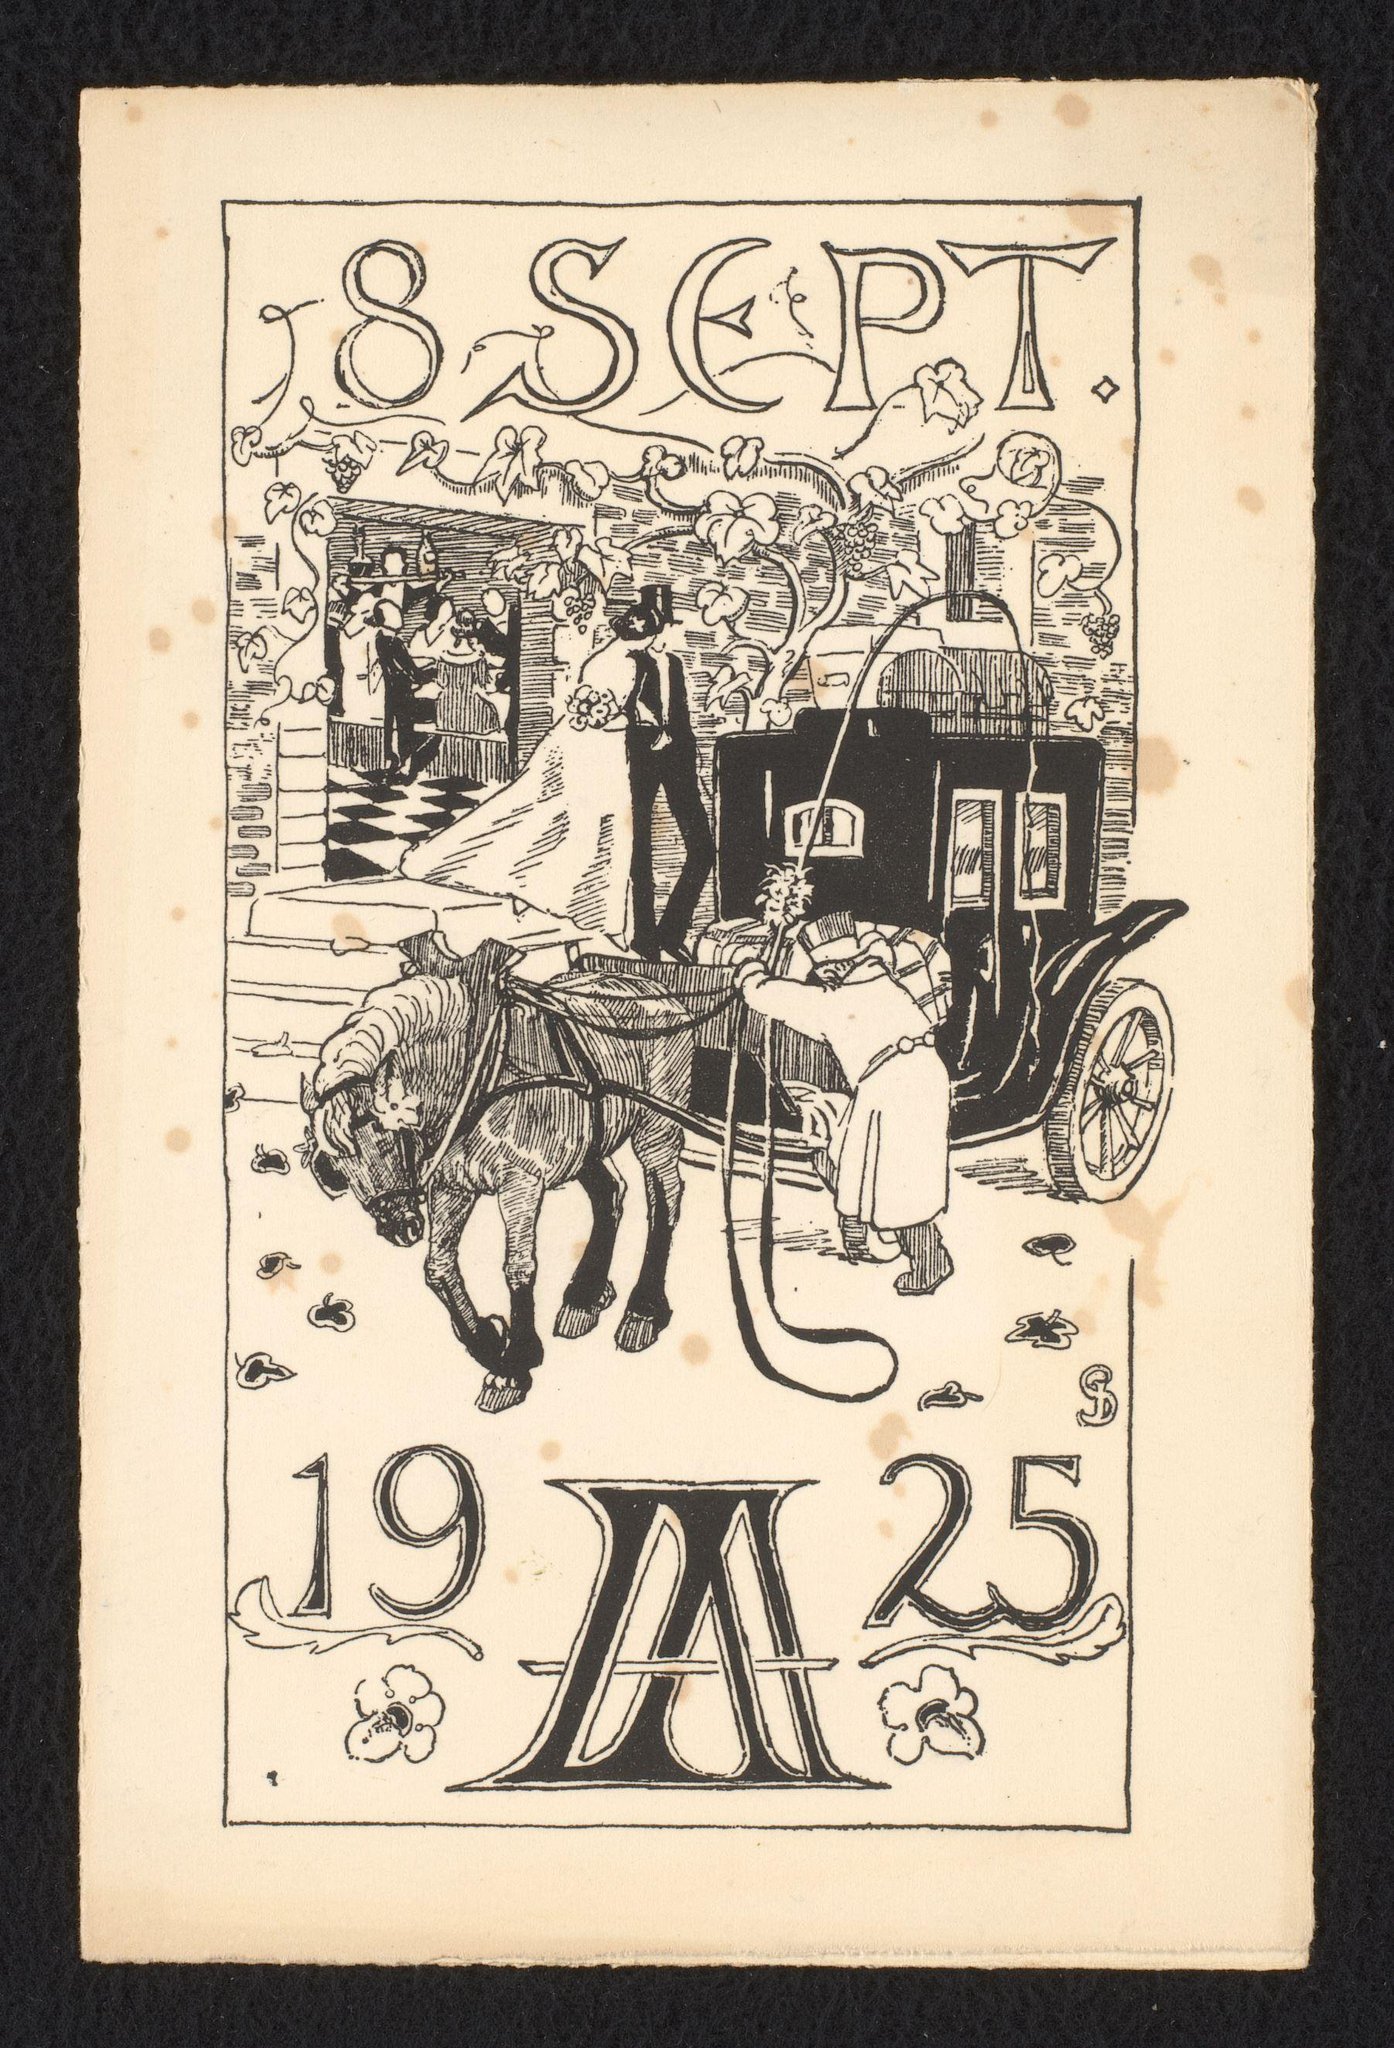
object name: print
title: Menukaart voor een huwelijk op 8 september 1925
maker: Anonymous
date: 1925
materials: paper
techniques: letterpress printing, lithograph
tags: wedding feast, wedding meal, four-wheeled, animal-drawn vehicle, e.g.: cab, carriage, coach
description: Op de voorzijde komt het getrouwde paar een gebouw uit en loopt naar een koets, terwijl binnen het feest voortduurt. Binnenin het menu van het diner.